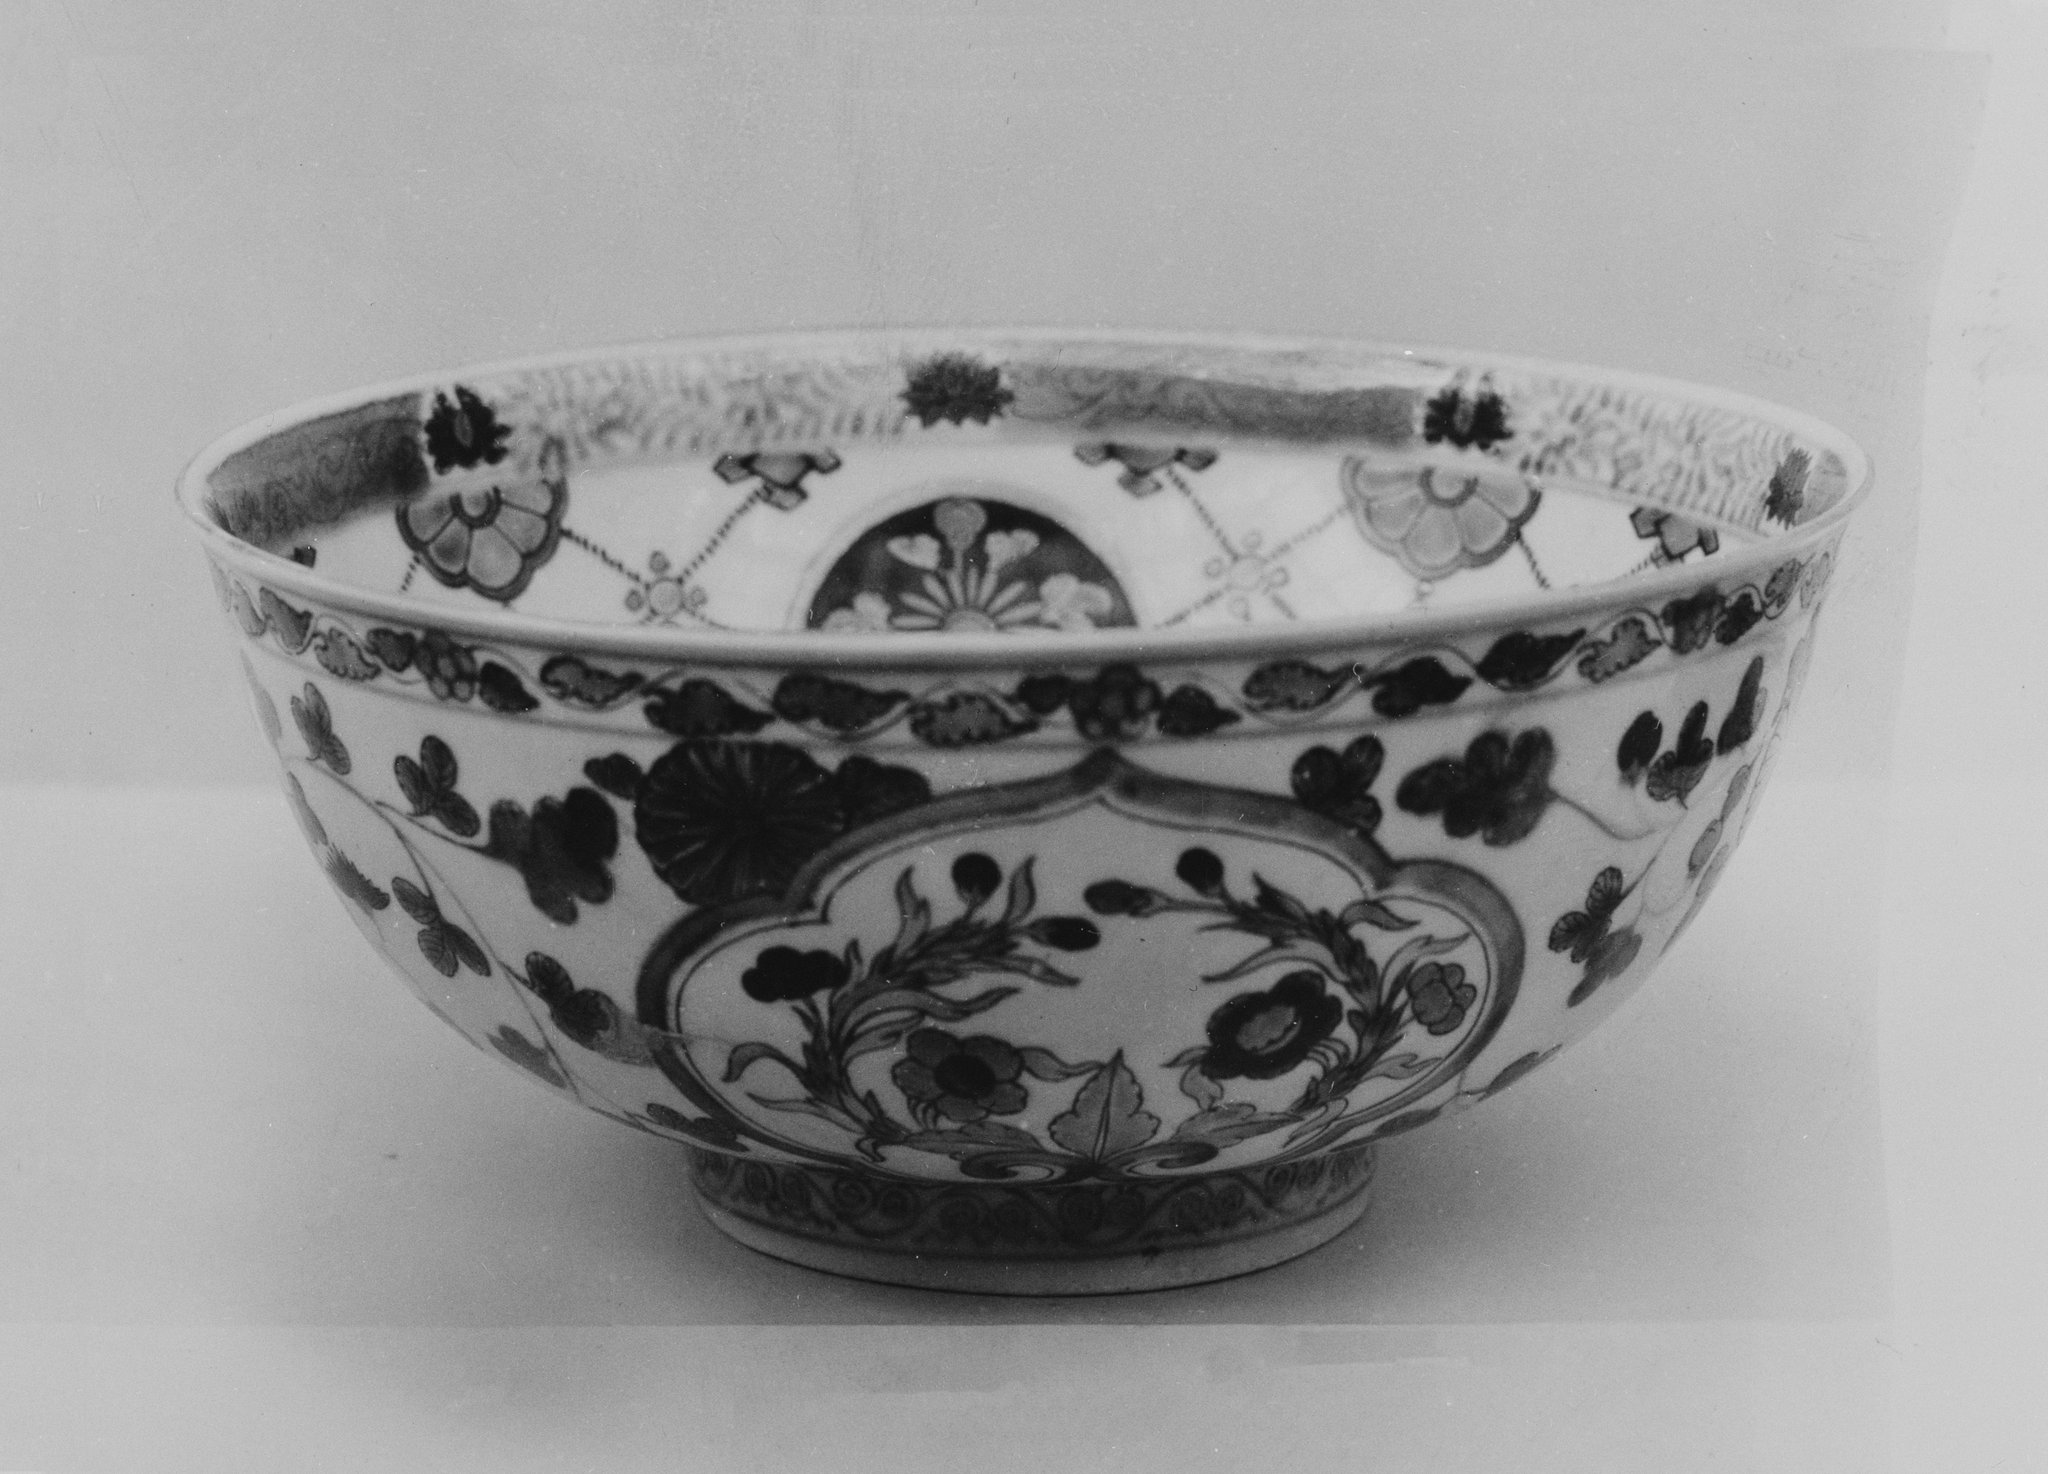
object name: bowl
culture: japanese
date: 1750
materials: enamel, glaze, porcelain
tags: flowers,leaves